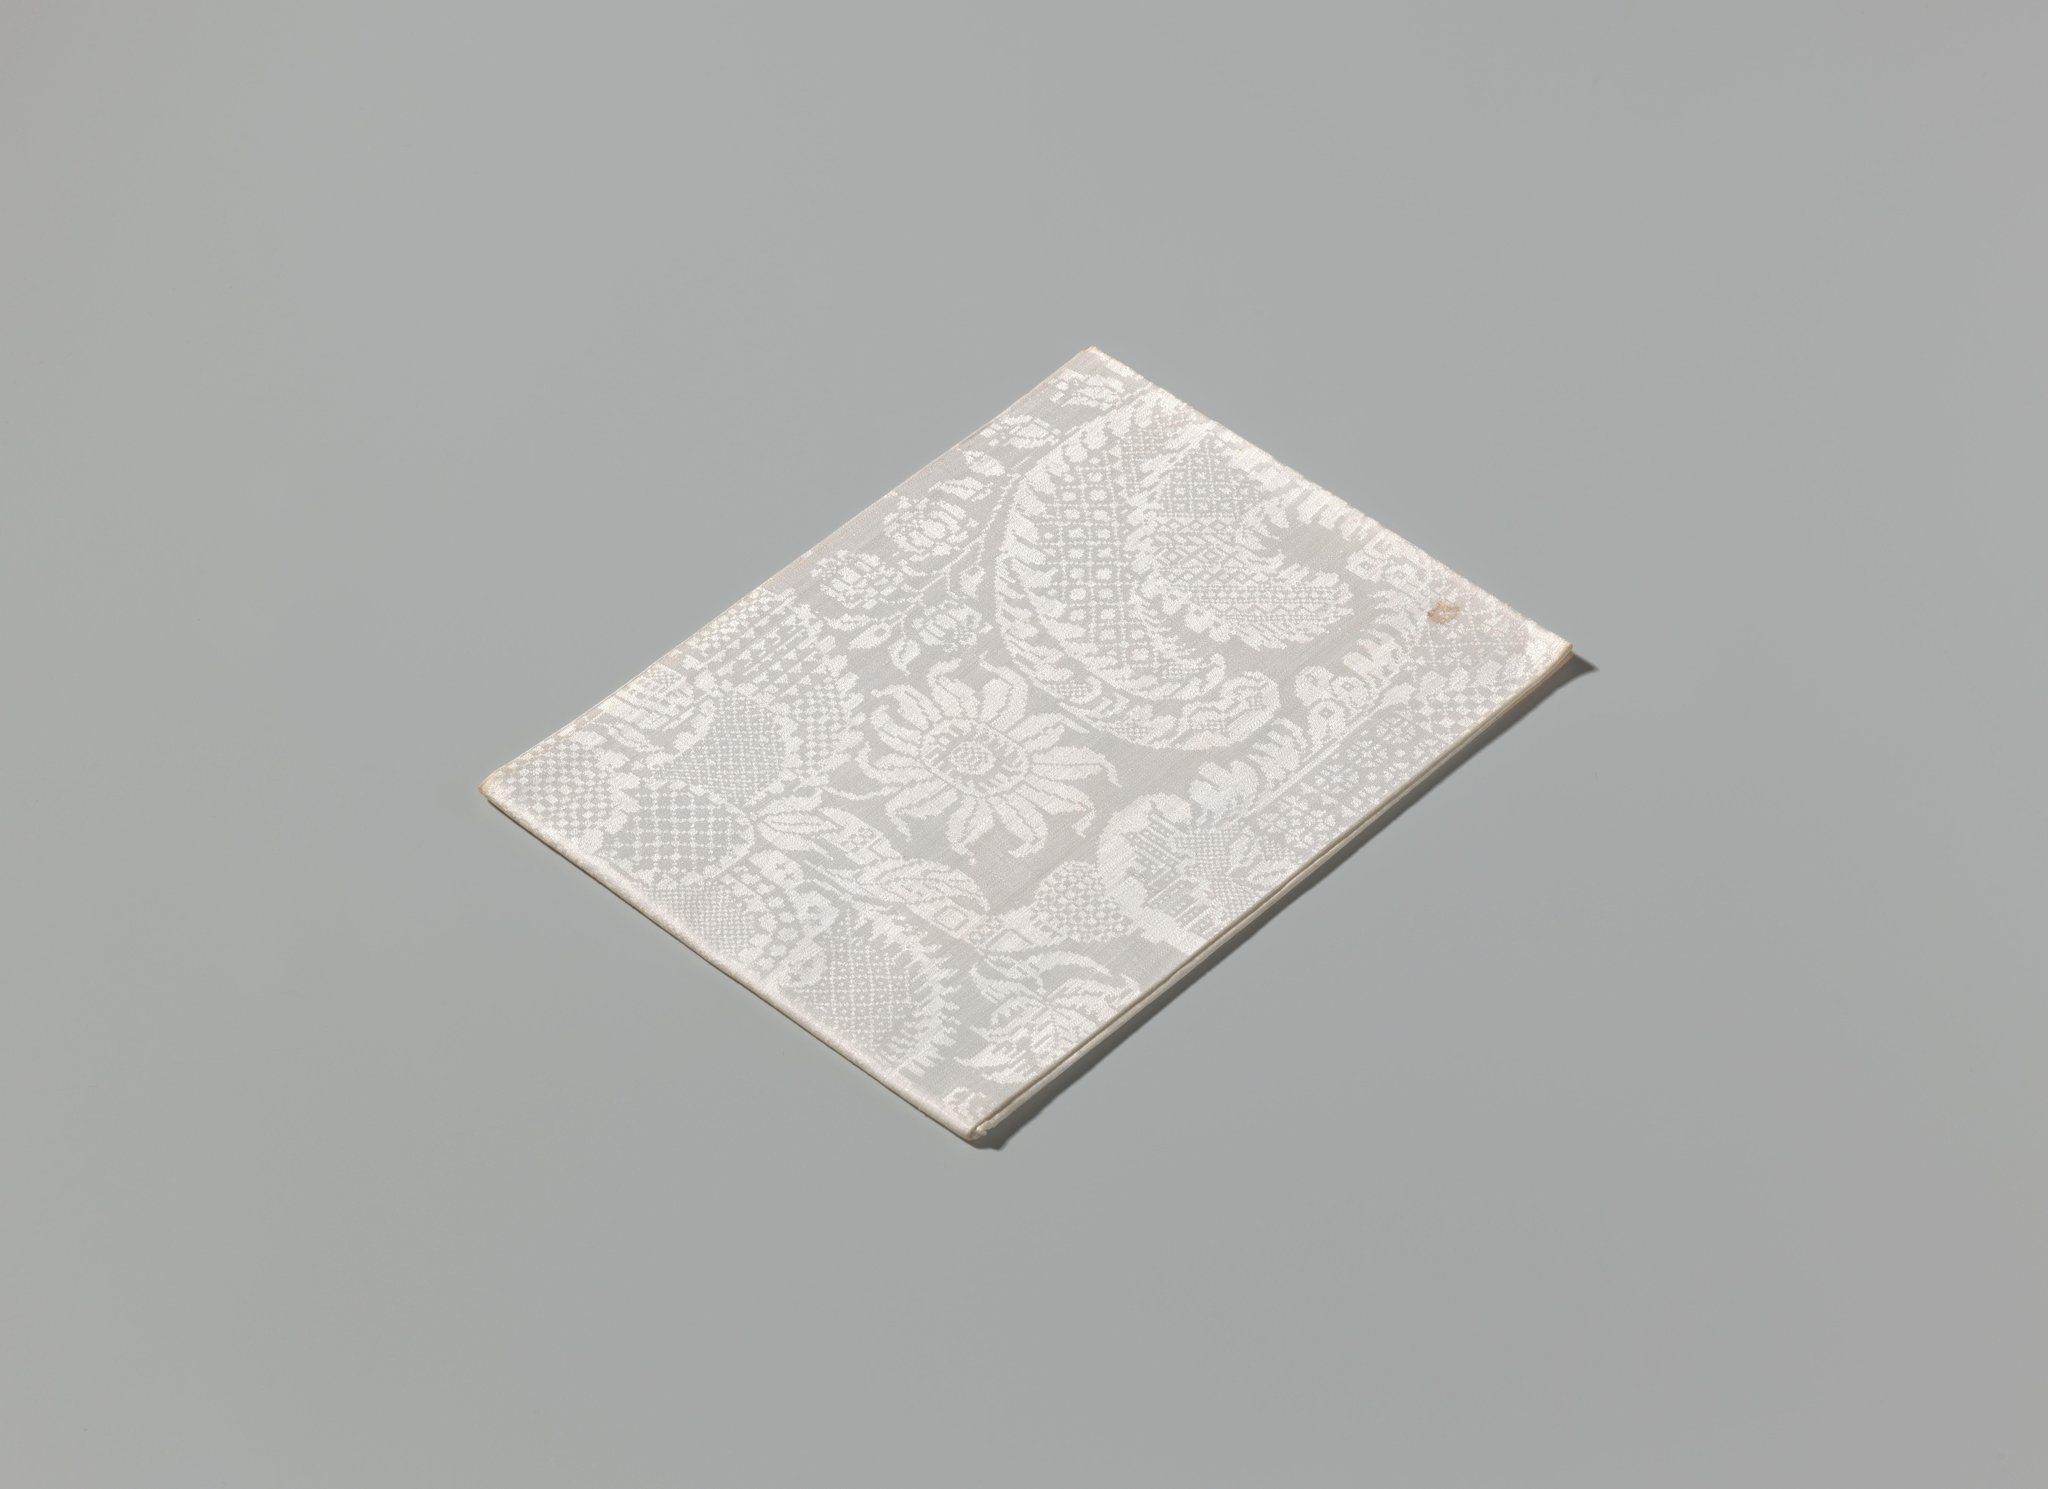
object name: napkin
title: Servet van linnendamast met een voluutpatroon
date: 1723-1730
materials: linen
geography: northern netherlands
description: Wit linnendamasten servet met patroon van voluten, merk: kroon WG 26.